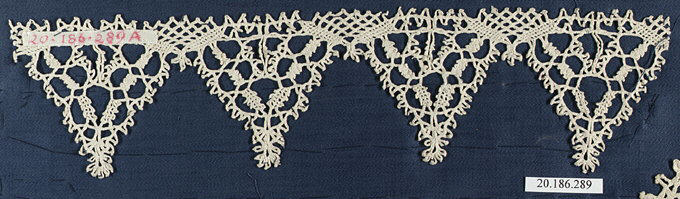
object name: edging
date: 1501-1600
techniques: lace